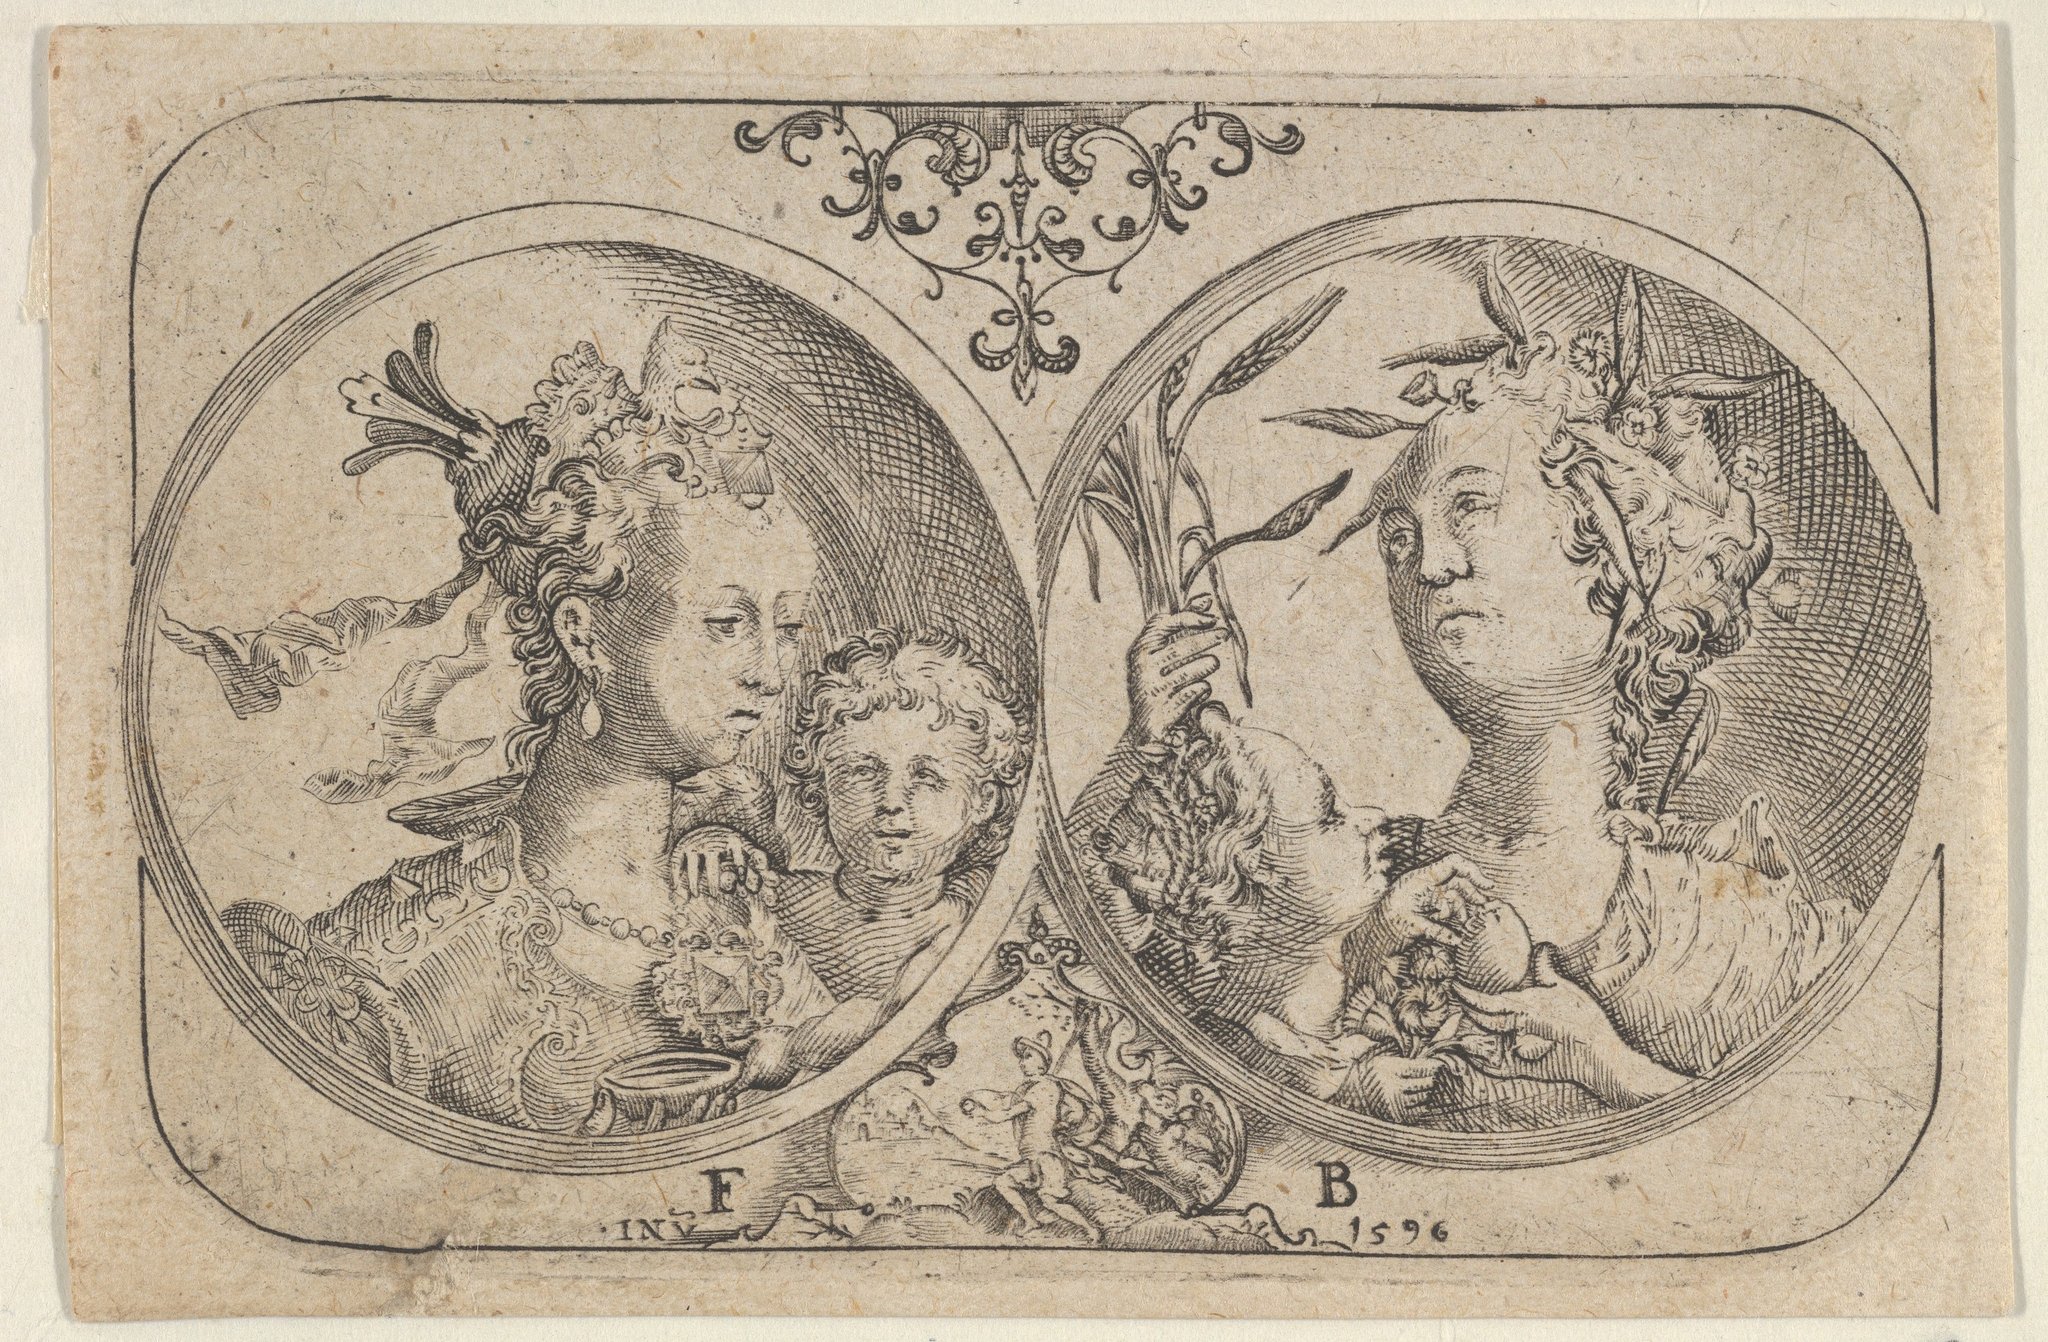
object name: print ornament architecture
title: Horizontal Panel with Two Medallions Containing Cupid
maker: floris balthasarsz van berckenrode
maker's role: artist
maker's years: 1562-1616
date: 1596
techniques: engraving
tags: portraits,women,cupid